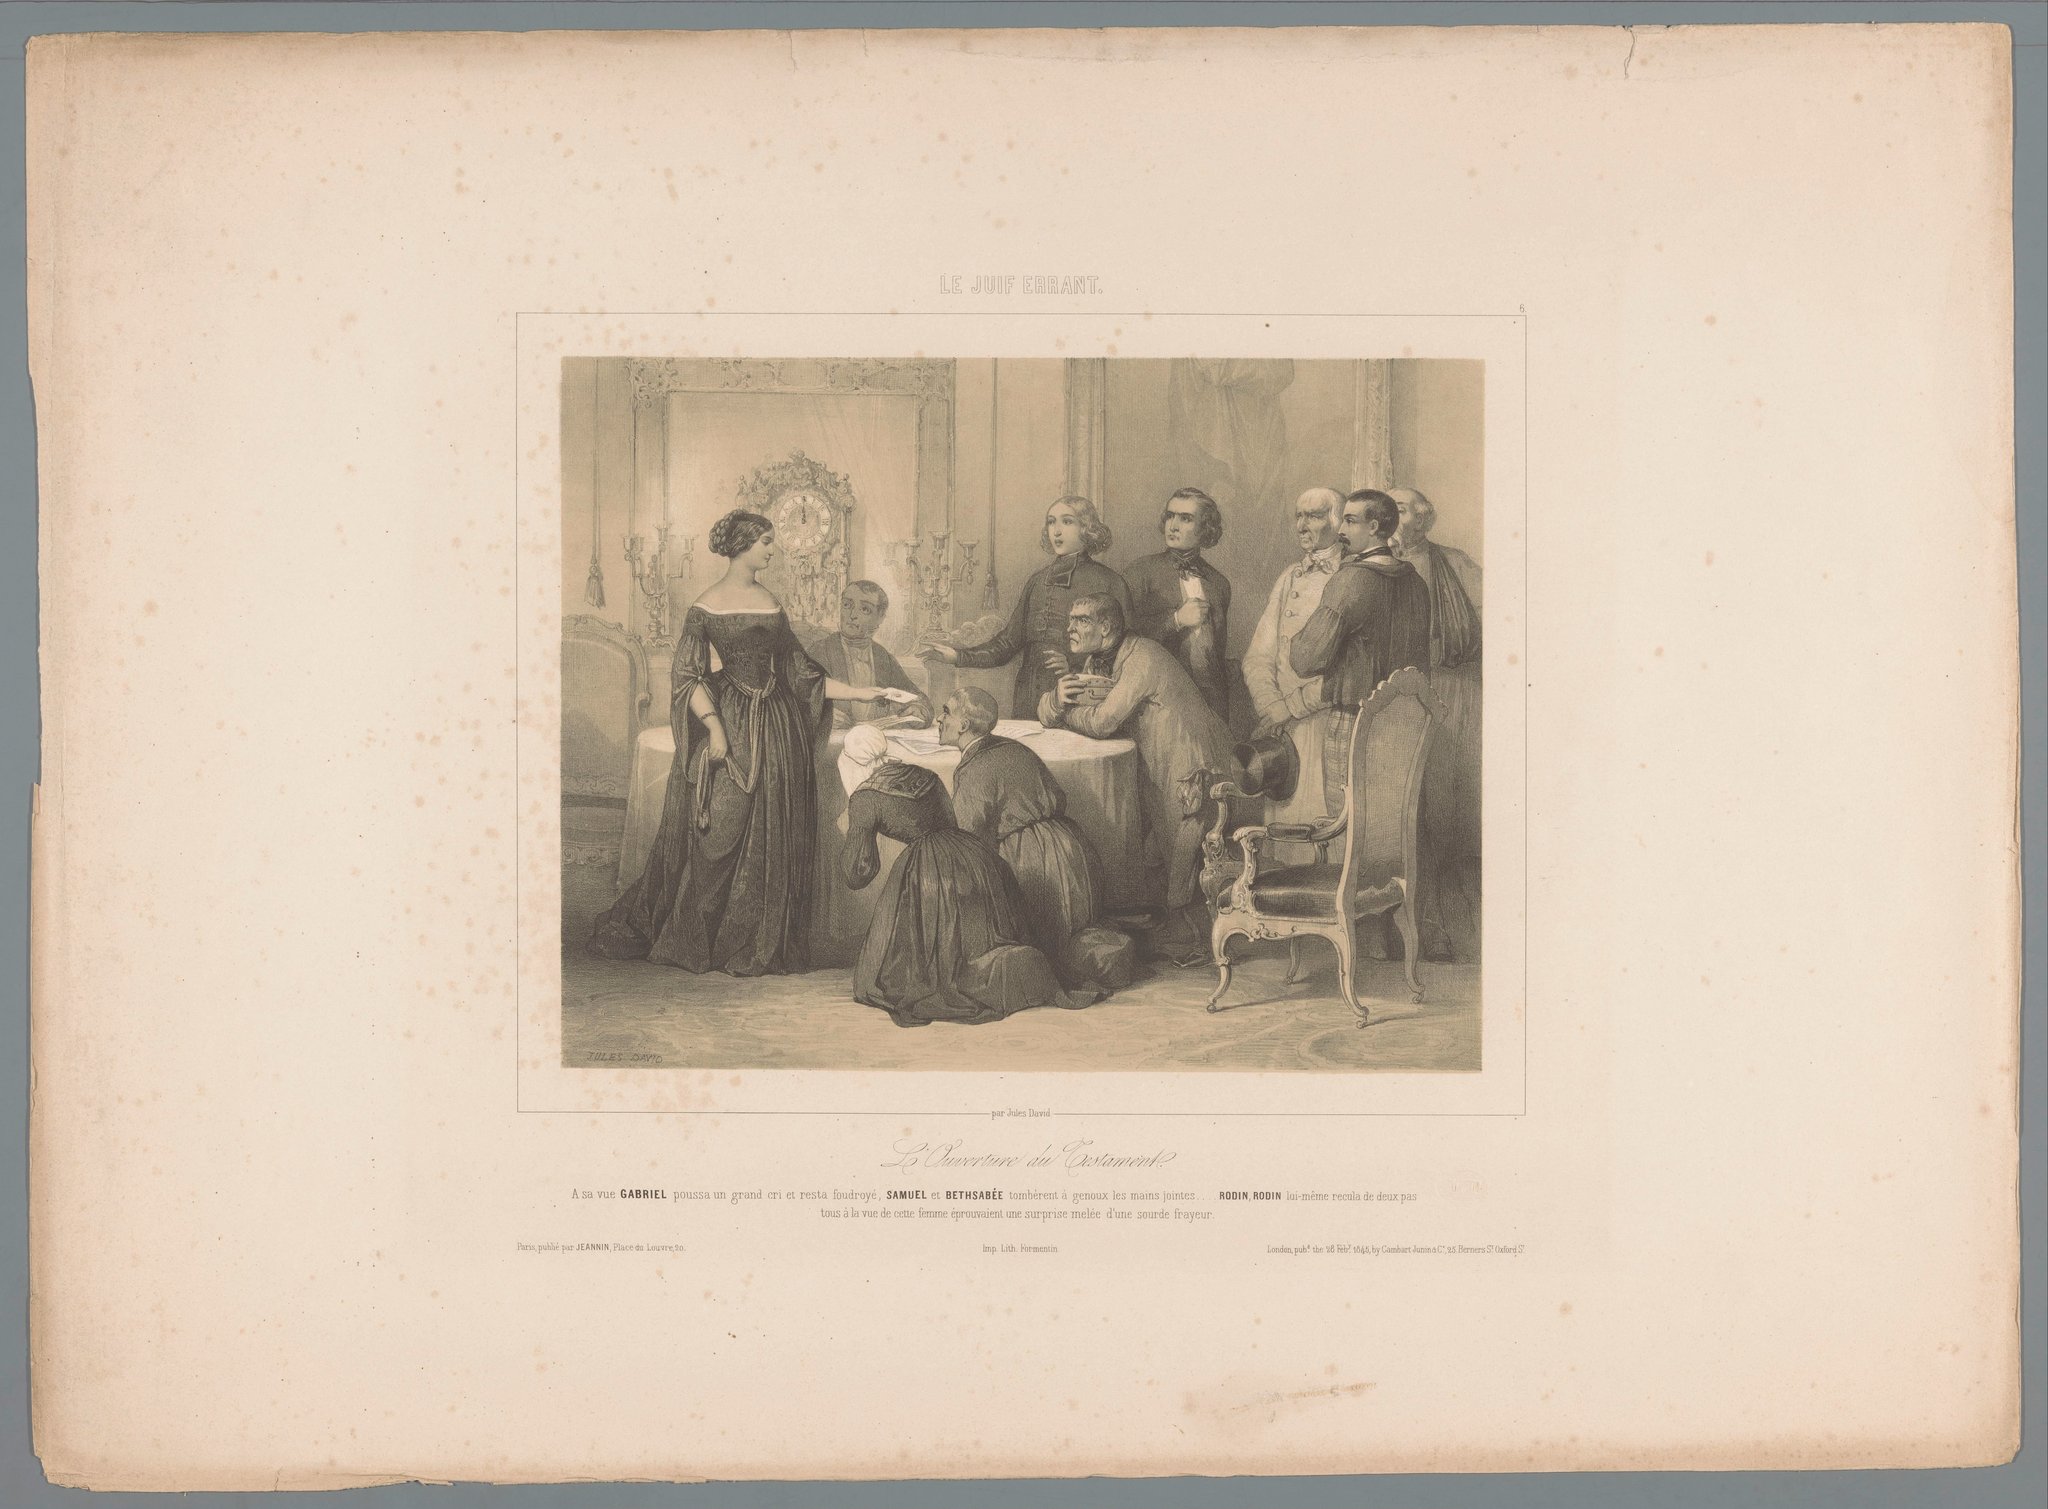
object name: print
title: Hérodiade presenteert het testament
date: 1844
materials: paper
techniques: tone lithography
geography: paris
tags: documents (~ witnesses), making a testament, interior of the house, paris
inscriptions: check stamp: Lugt 1397c, collector's mark: Lugt 2228a, check stamp: Lugt 3903